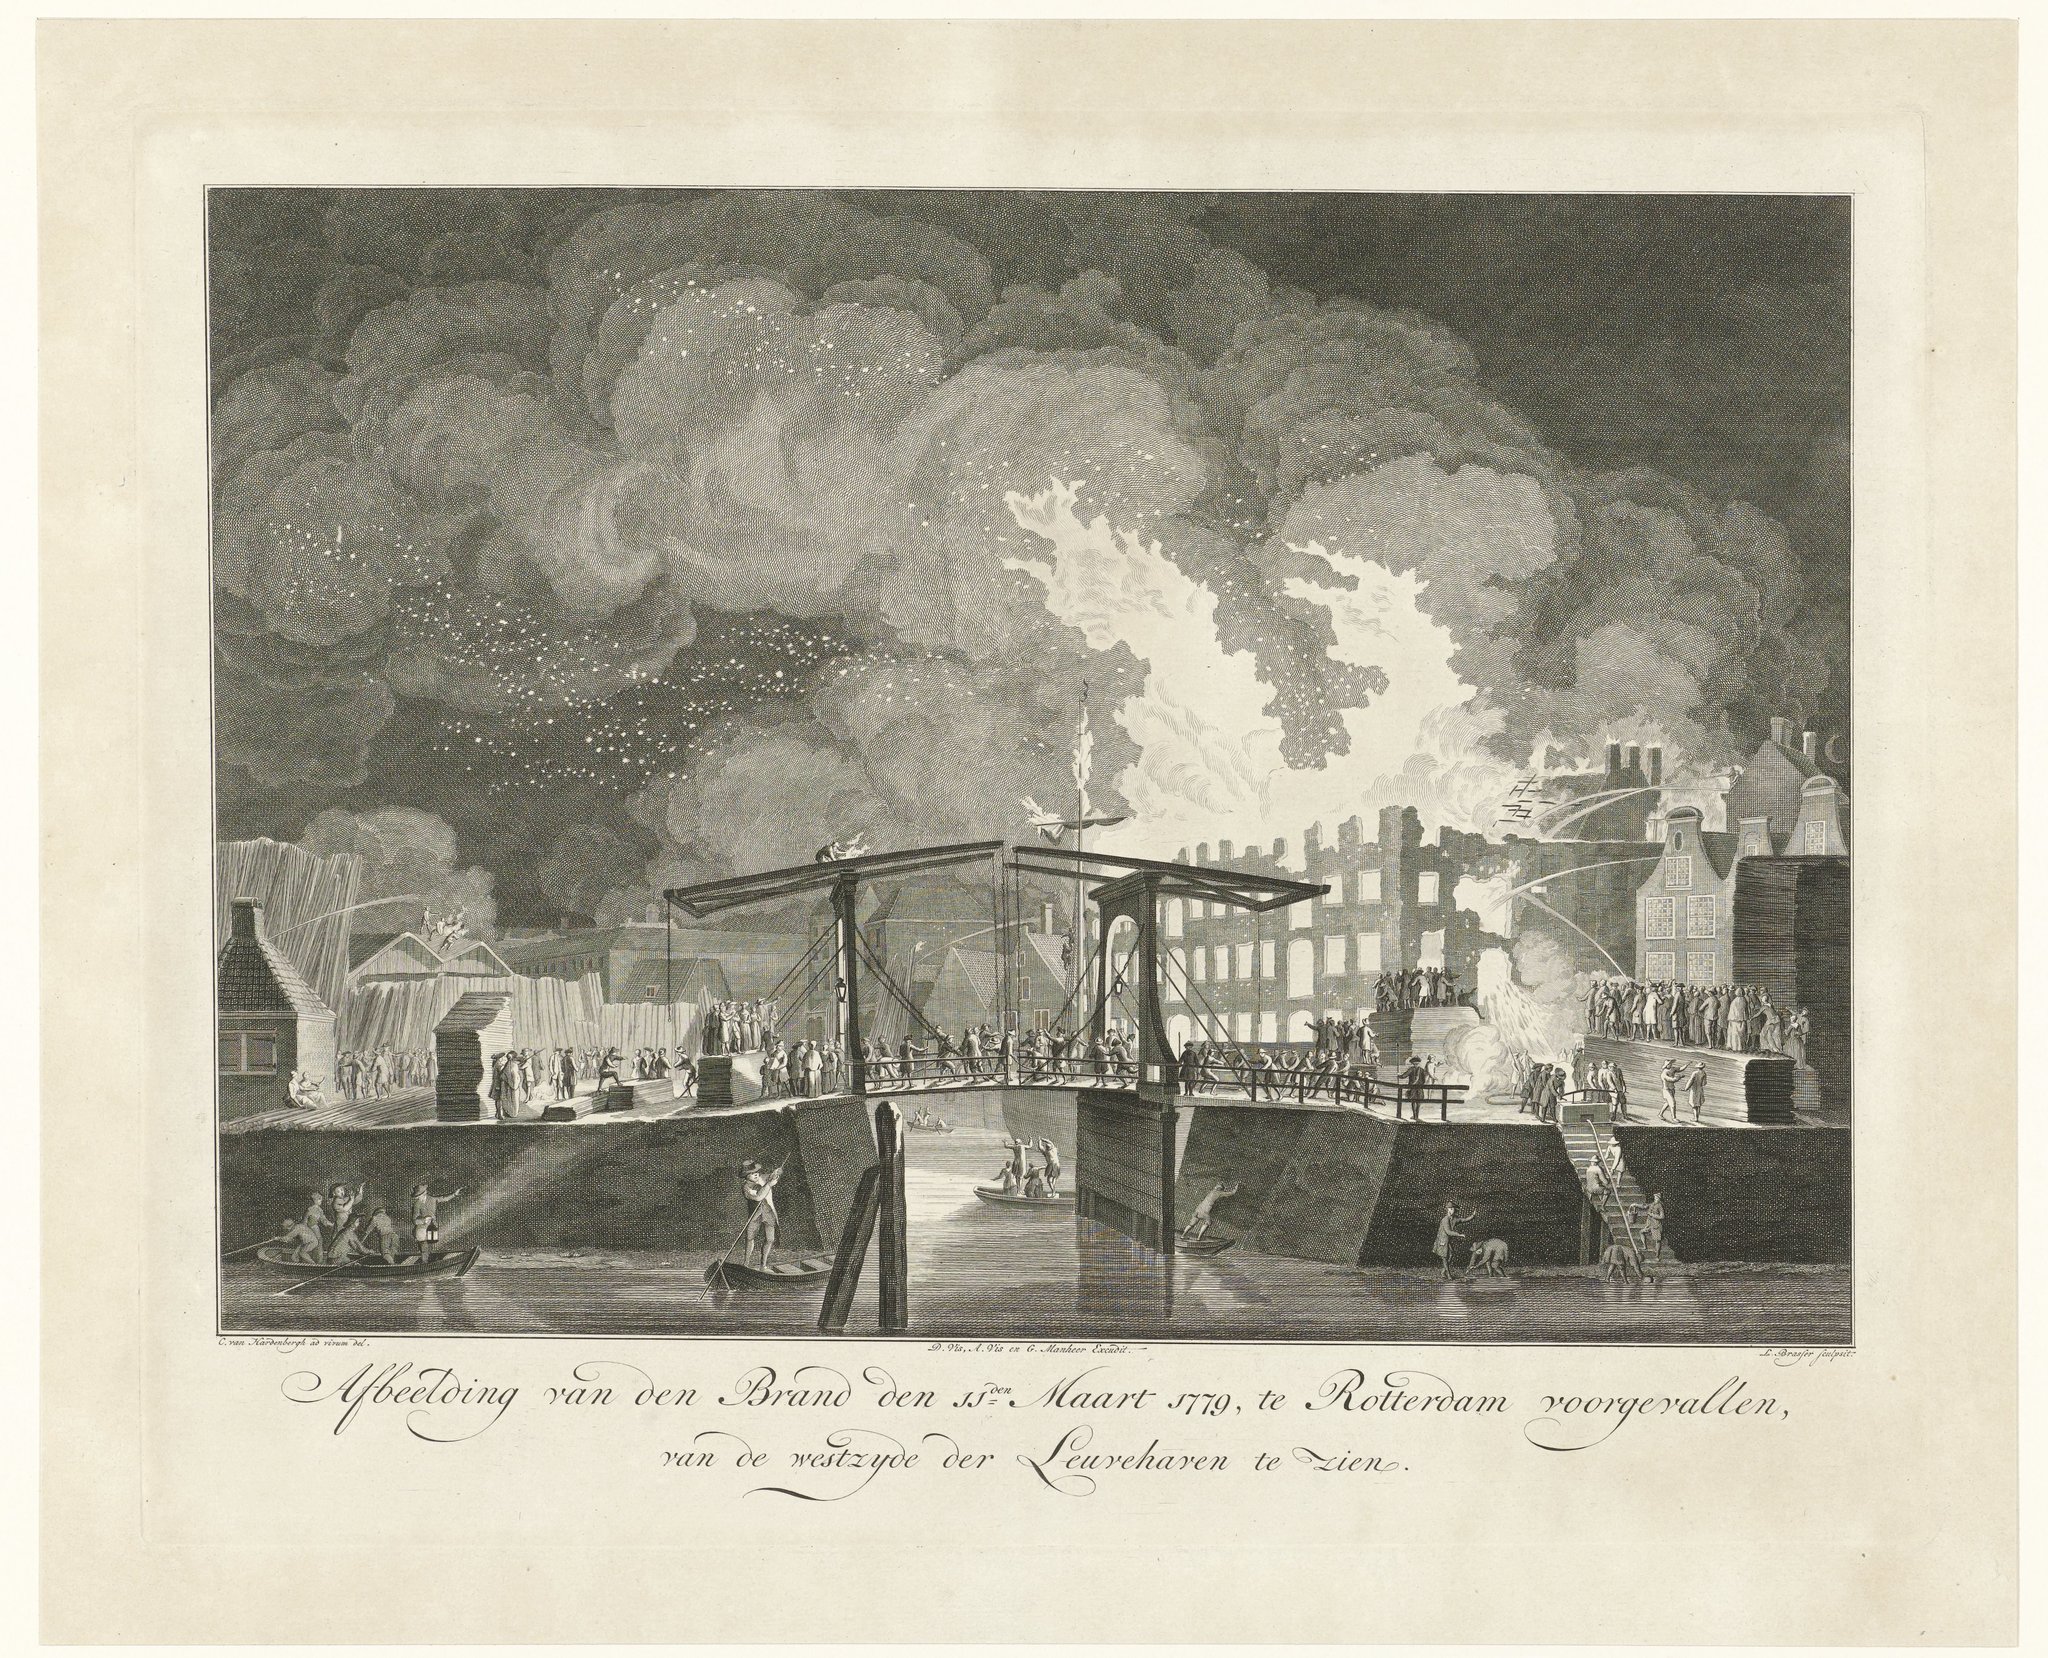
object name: print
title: Afbeelding van den Brand den 11den Maart 1779, te Rotterdam voorgevallen, van de westzyde der Leuvehaven te zien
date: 1779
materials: paper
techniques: engraving, etching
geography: rotterdam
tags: on fire, ablaze, rotterdam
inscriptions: collector's mark: Lugt 2228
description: Grote brand in enkele huizen in de Pottebakkerssteeg te Rotterdam, 11 maart 1779. Grote menigte op straat, met brandspuiten wordt geprobeerd de brand te blussen. Gezien vanuit de Leuvehaven met centraal de Scheluwebrug.